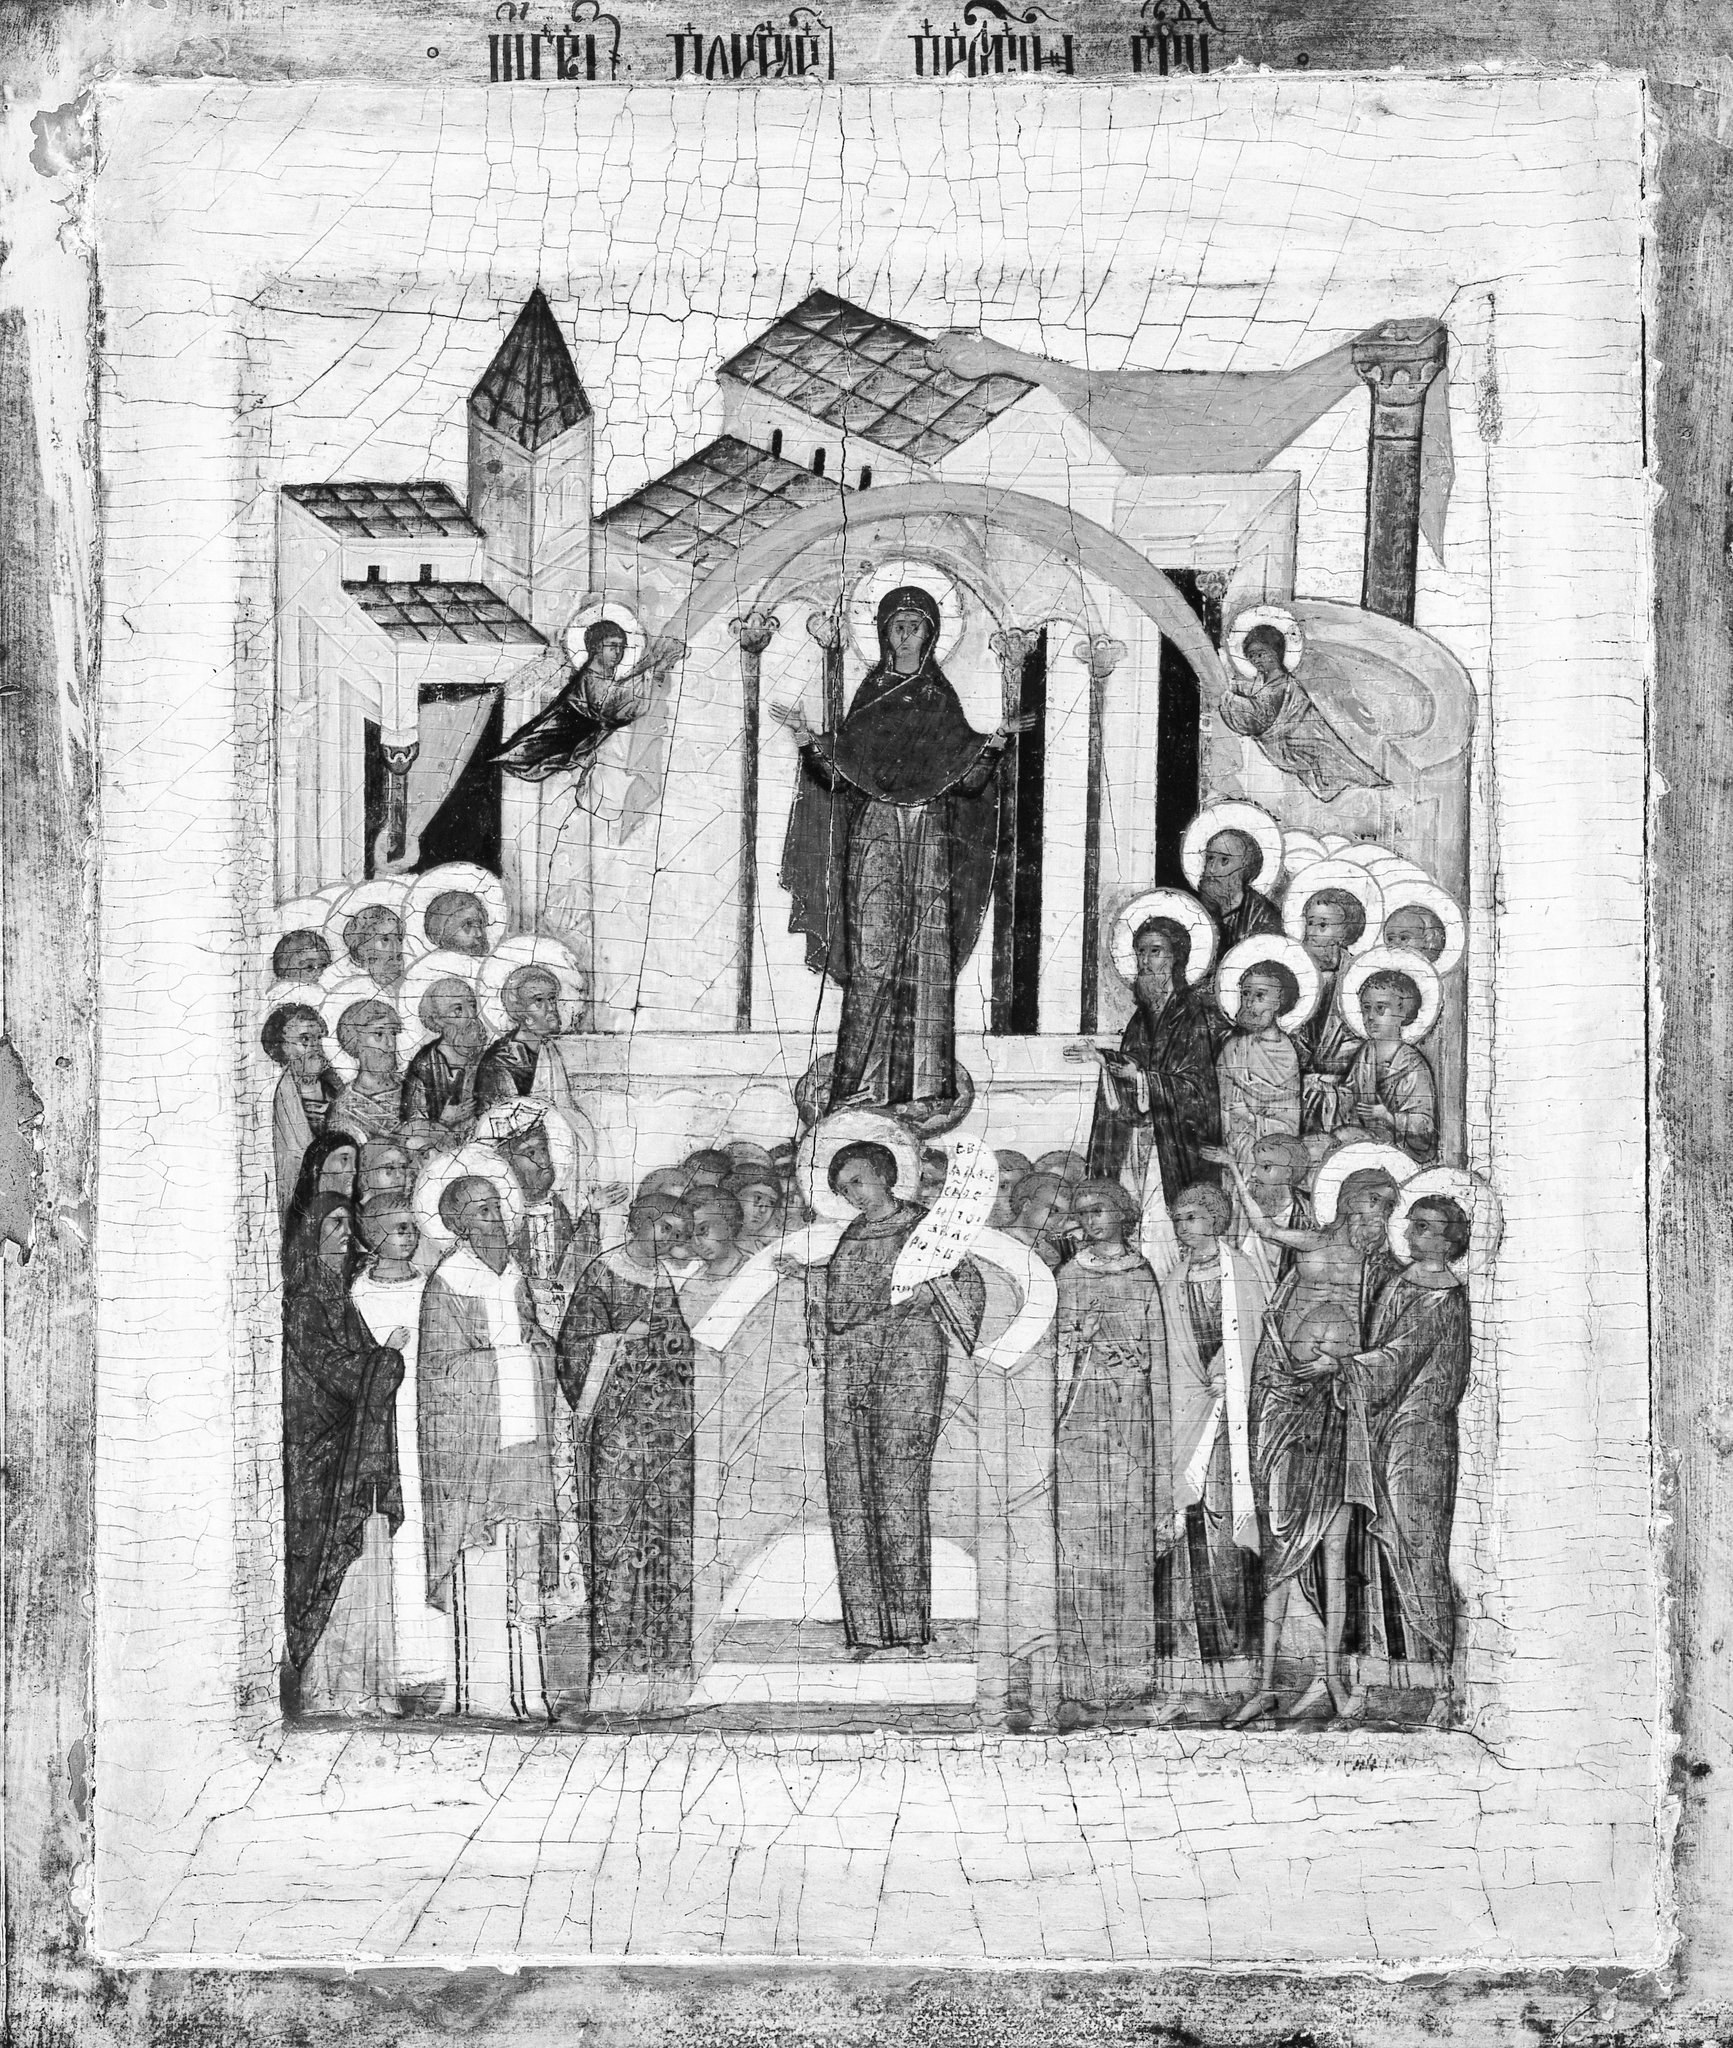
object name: painting, icon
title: The Protection of the Mother of God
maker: russian painter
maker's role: artist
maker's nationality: russian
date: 1500-1599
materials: paint, wood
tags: men,women,virgin mary,saints